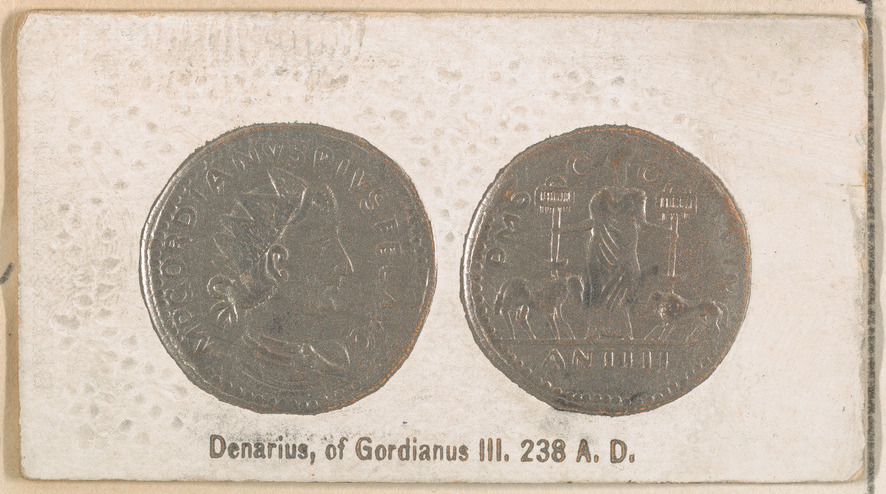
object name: print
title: Denarius of Cordianus III, 238 A.D., from the Ancient Coins series (N180) issued by Wm. S. Kimball & Co.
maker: william s. kimball & company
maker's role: publisher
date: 1888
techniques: color lithograph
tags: men,coins